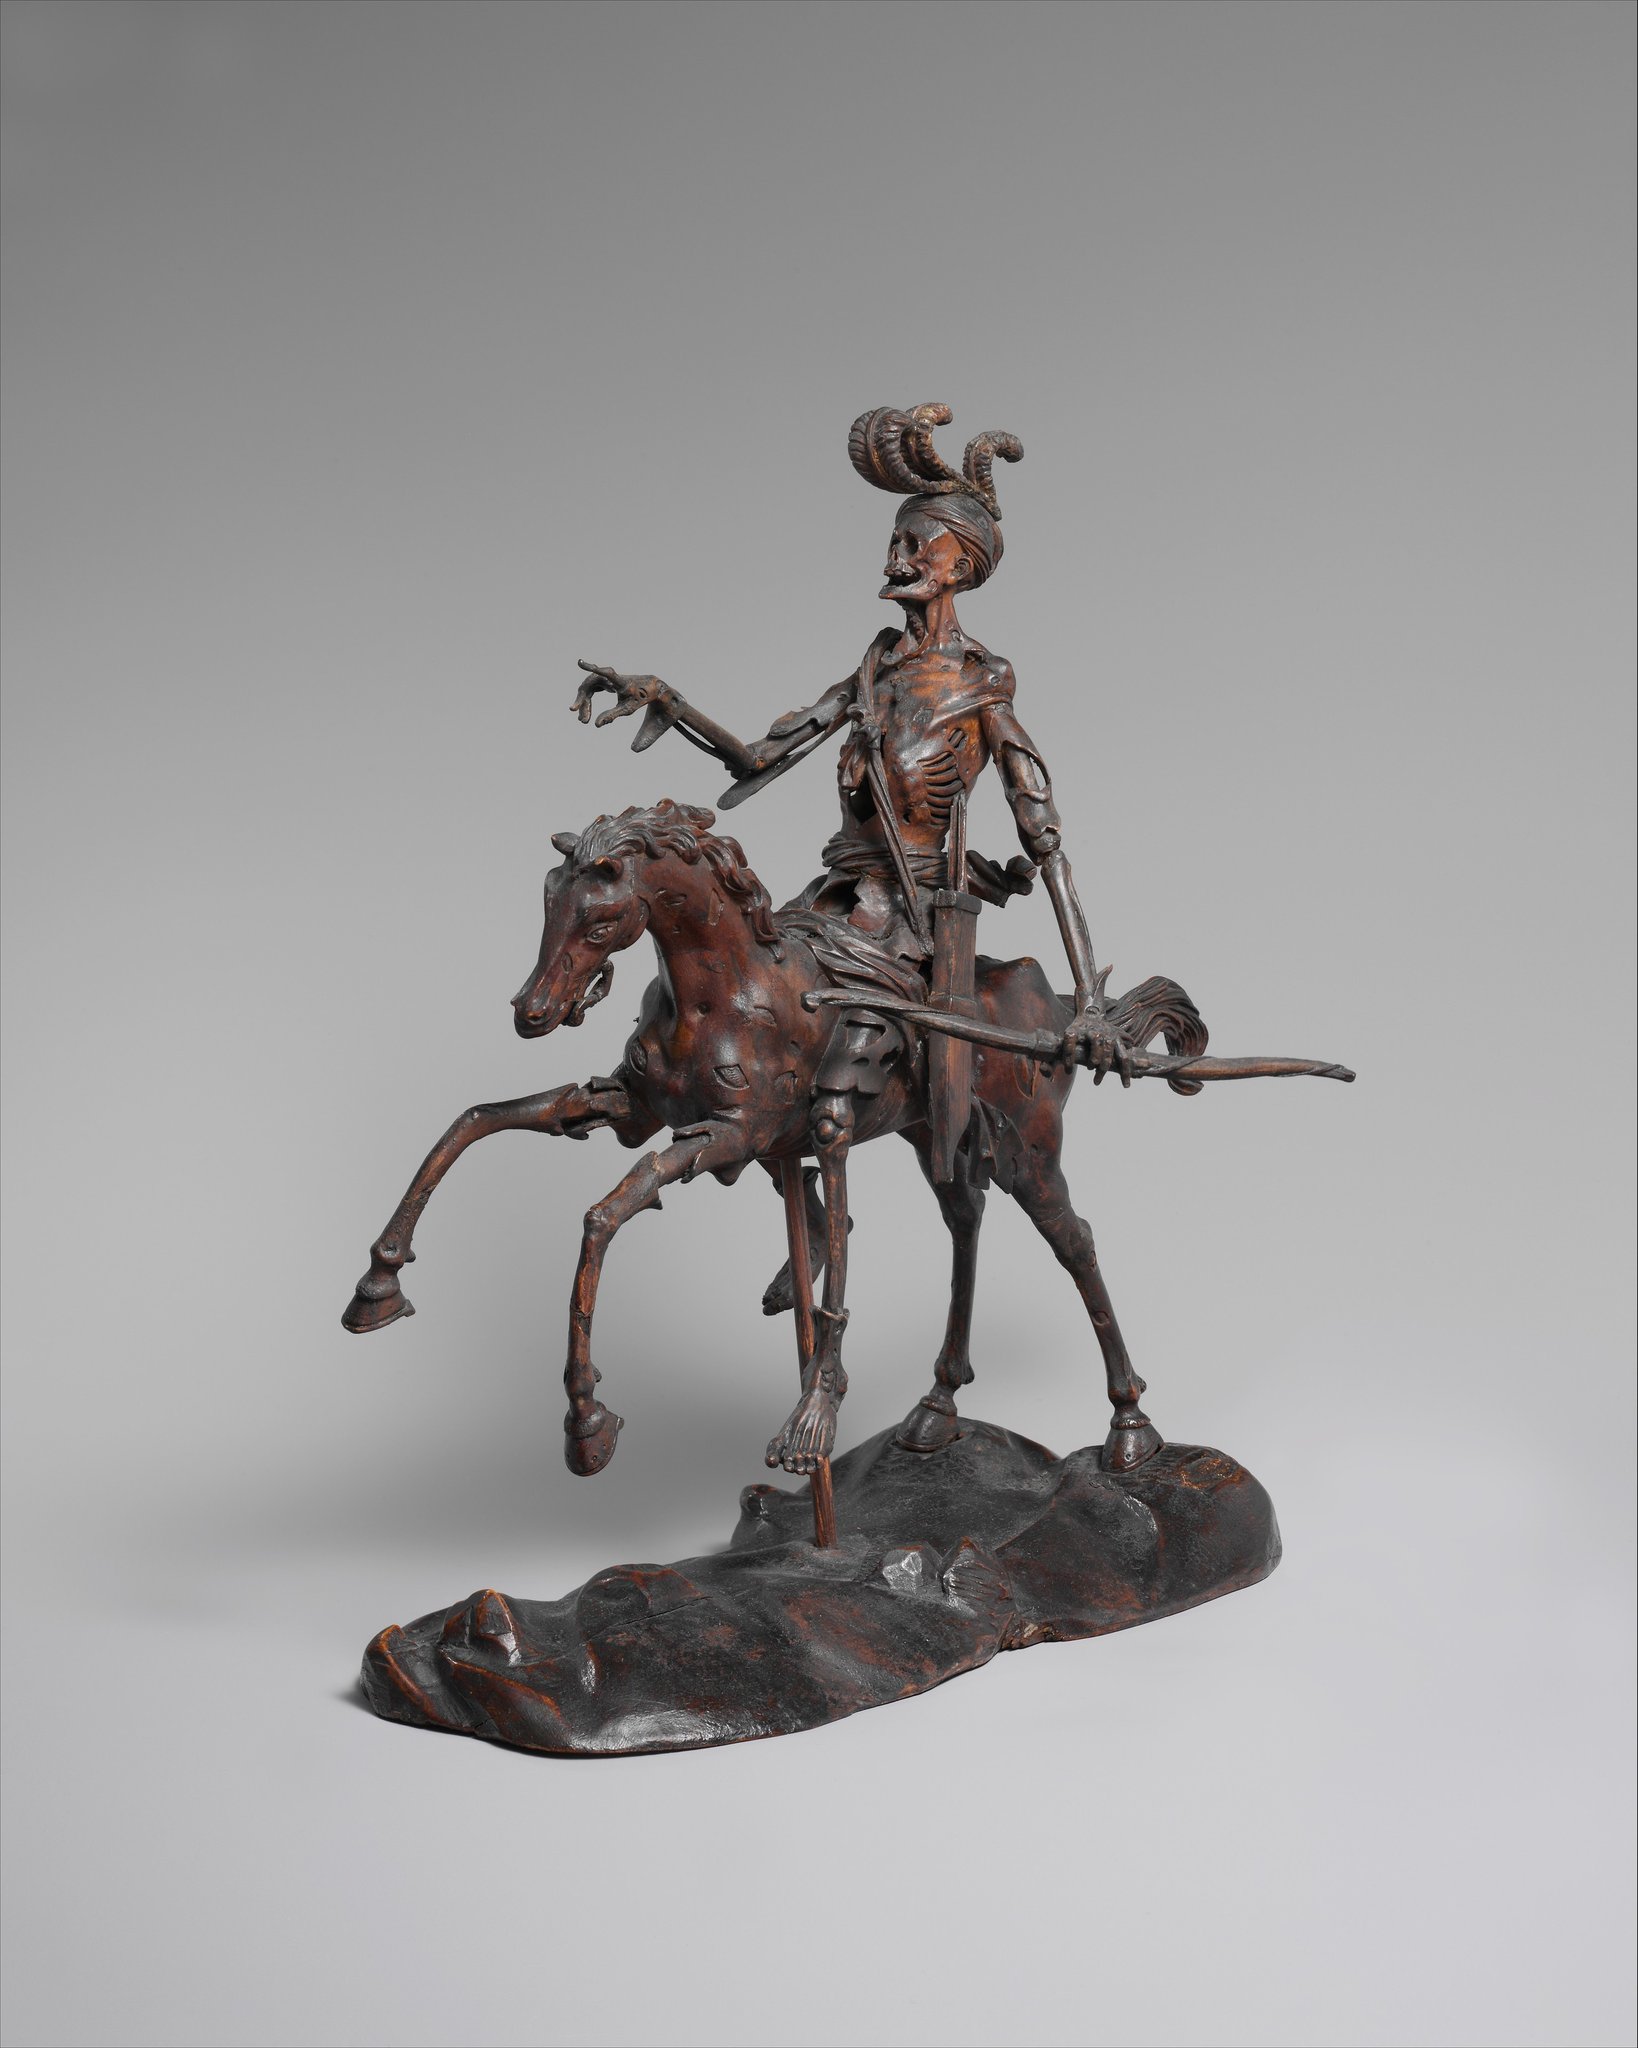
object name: statuette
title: Death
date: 1634-1666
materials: pigment, wood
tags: skeletons,horses,death